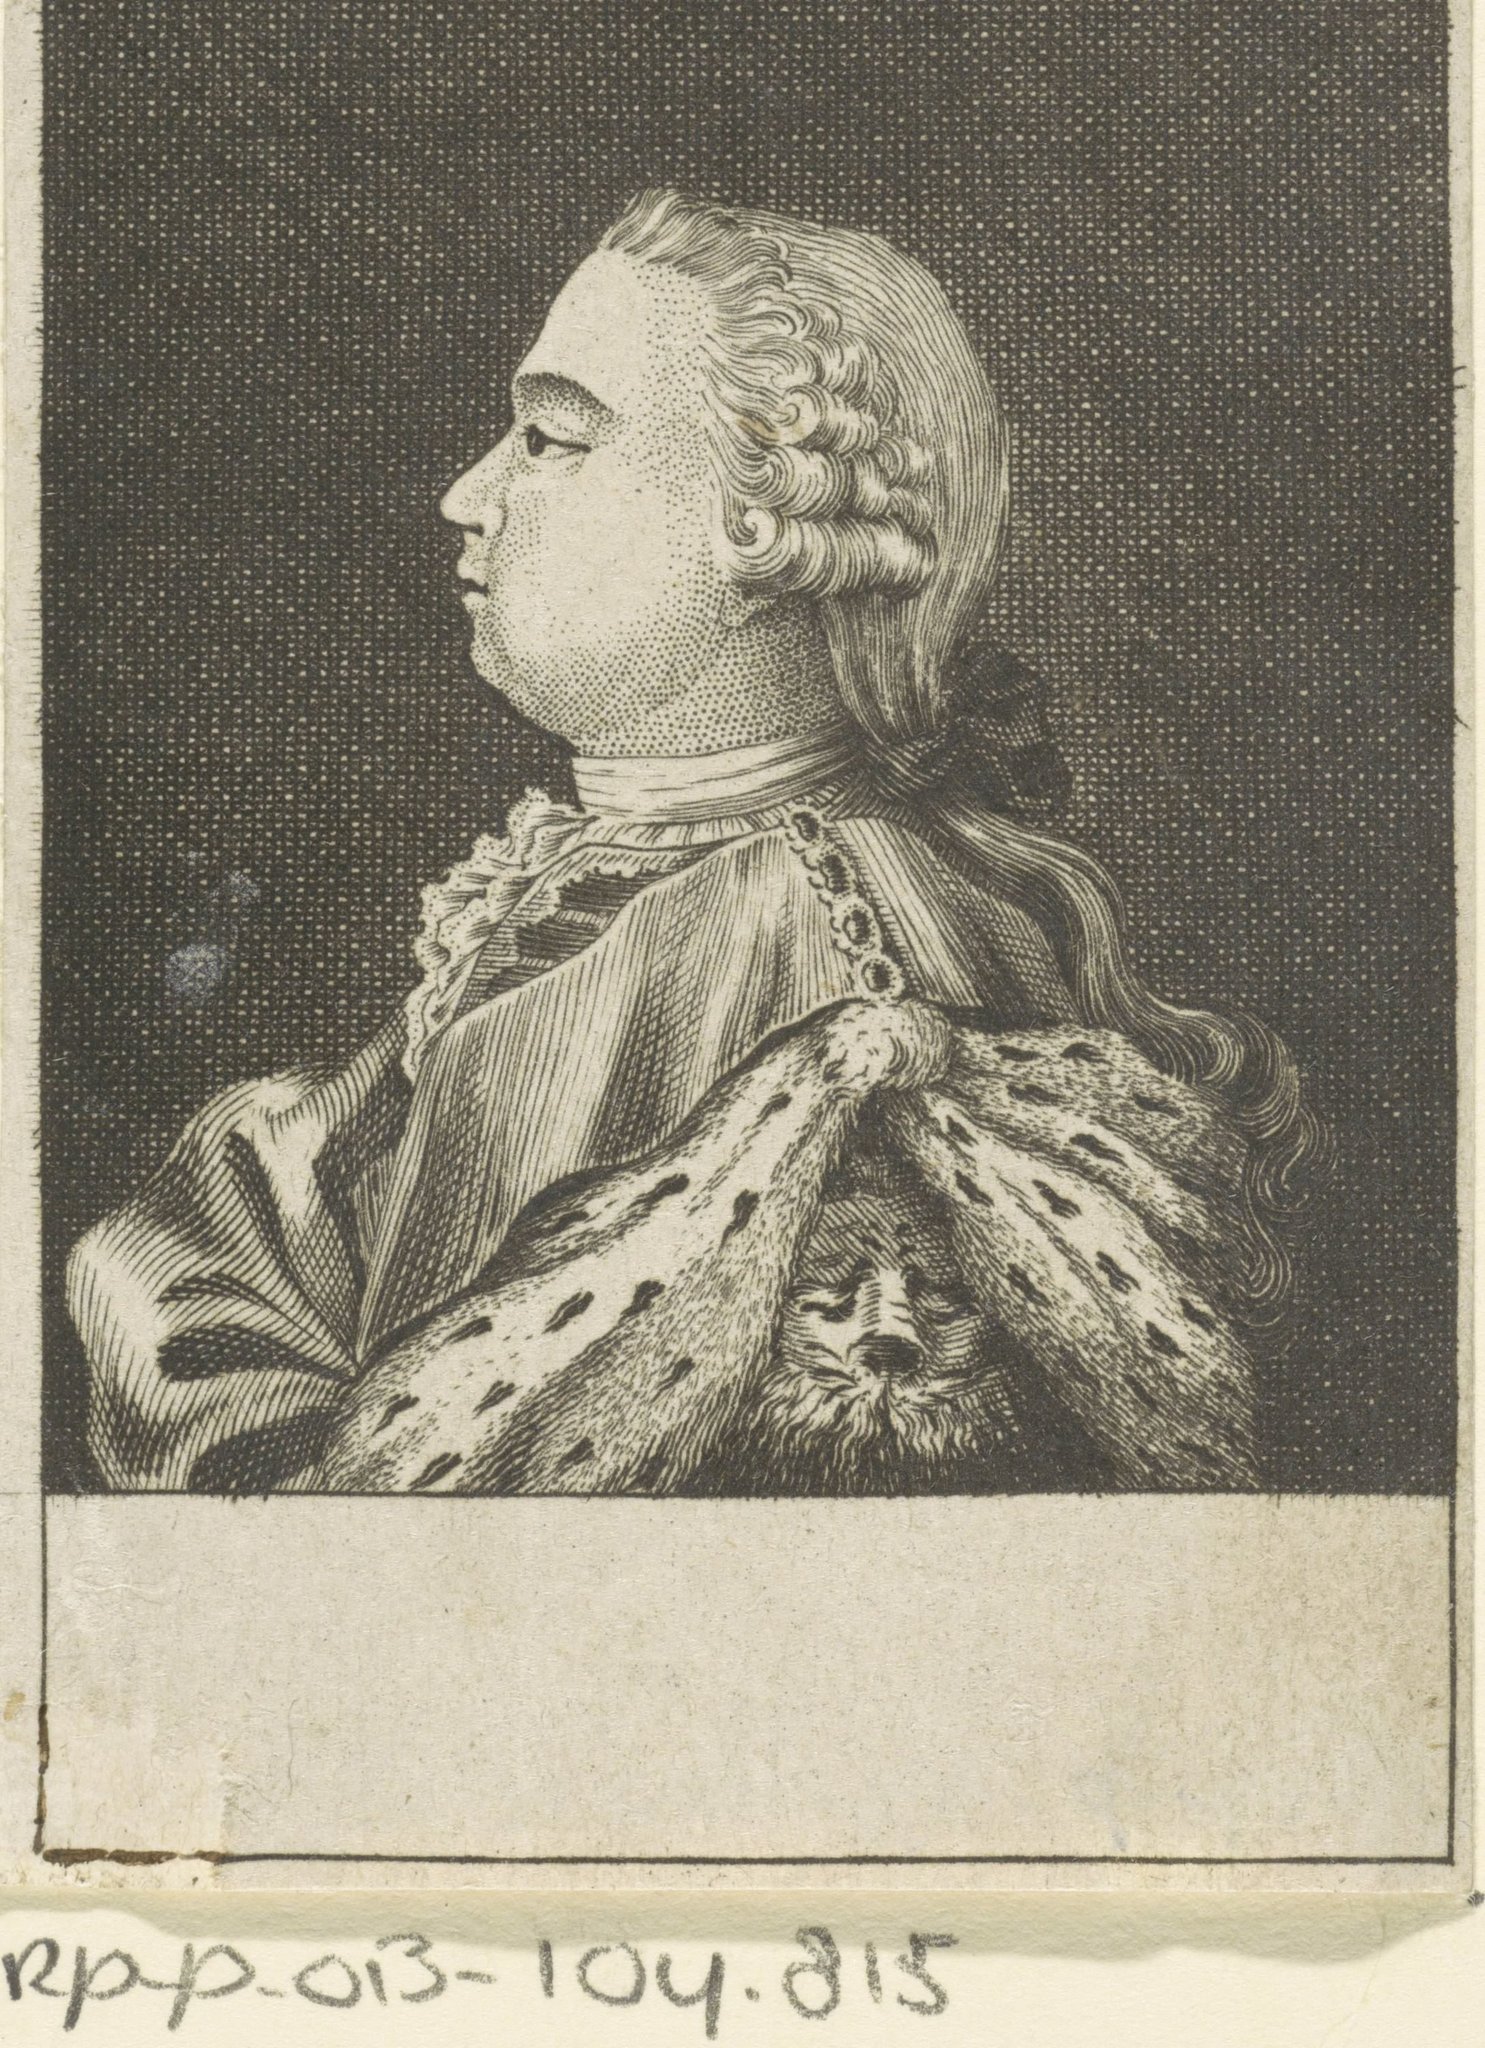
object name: print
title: Portret van Willem V, prins van Oranje-Nassau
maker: Anonymous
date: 1775-1849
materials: paper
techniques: engraving, etching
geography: low countries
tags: william v (prince of orange)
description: De hier vermelde titel verwijst naar de hoogst verkregen titel van de geportretteerde, niet per se naar de titel die de geportretteerde op deze voorstelling draagt.